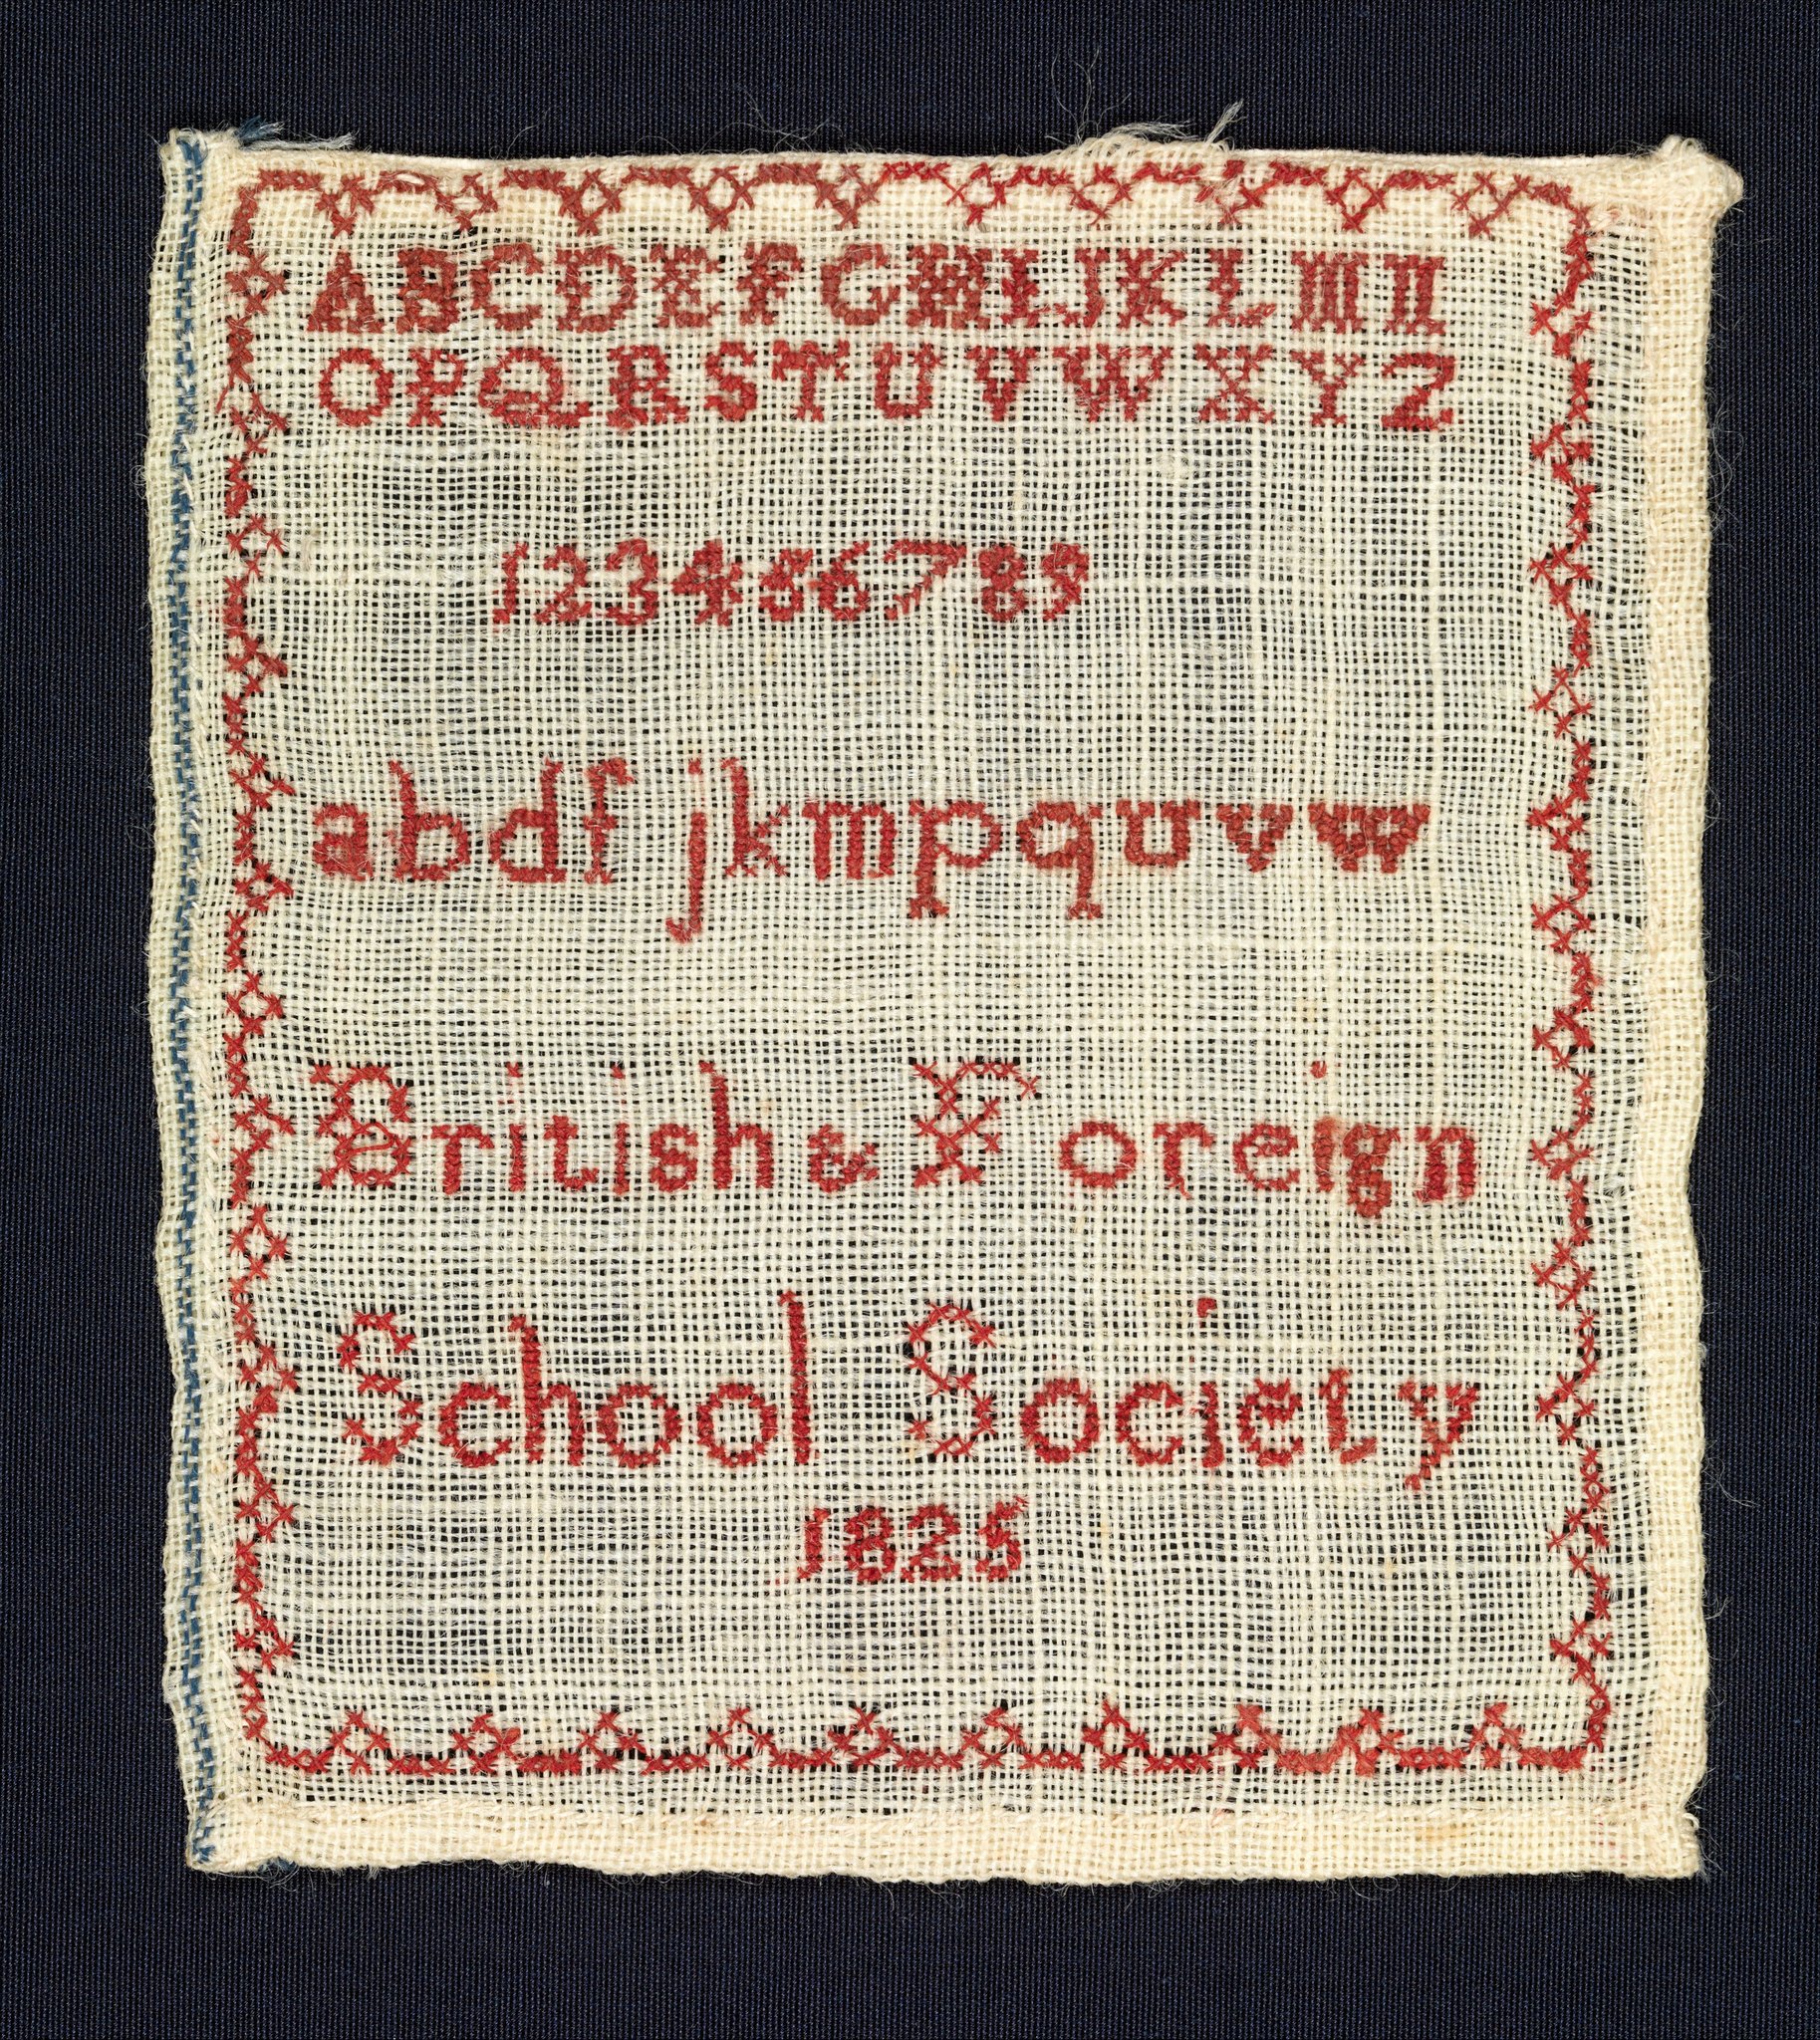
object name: sampler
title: Sampler made at the British and Foreign School Society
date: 1825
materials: cotton, wool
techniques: embroidery